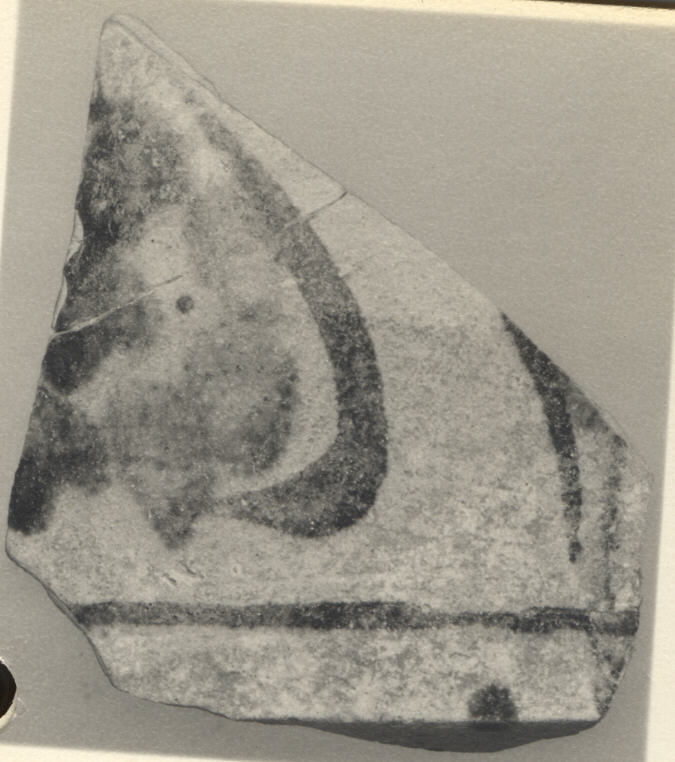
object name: fragment of a jar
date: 801-833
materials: earthenware, glaze, pigment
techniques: painting, polychrome, underglaze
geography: iran